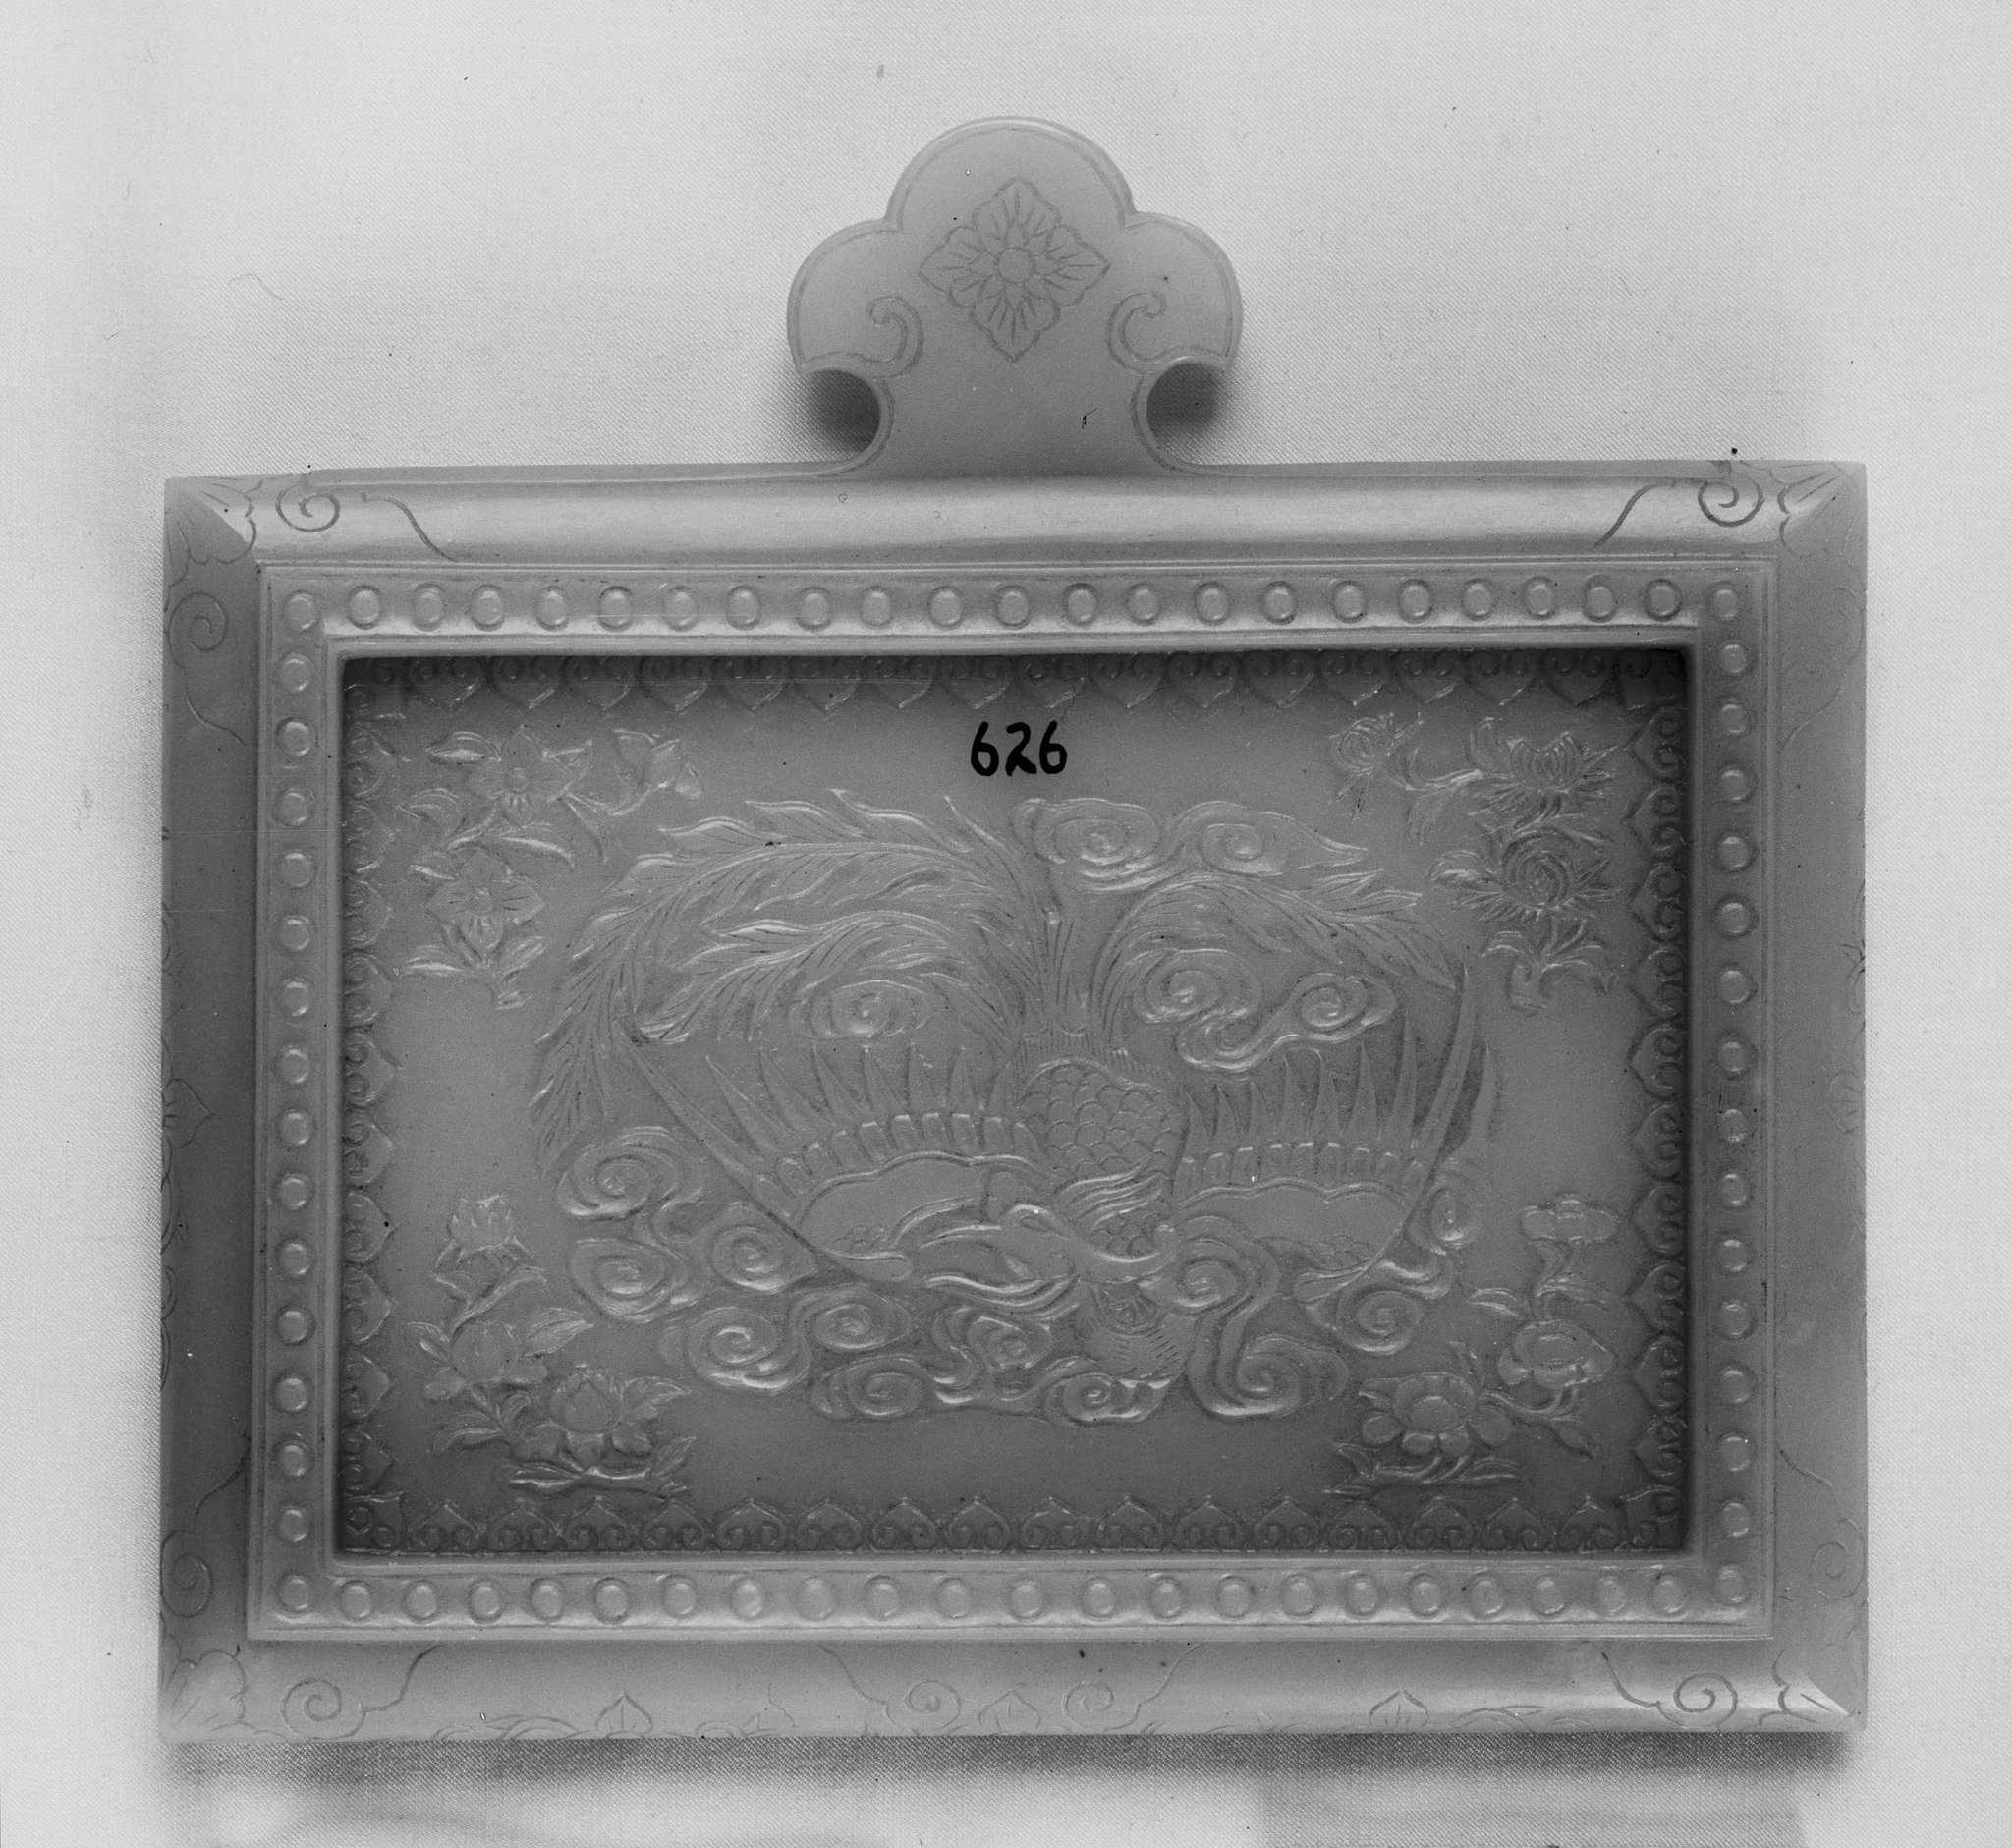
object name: mirror frame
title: Frame with mirror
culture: chinese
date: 1736-1795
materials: jade